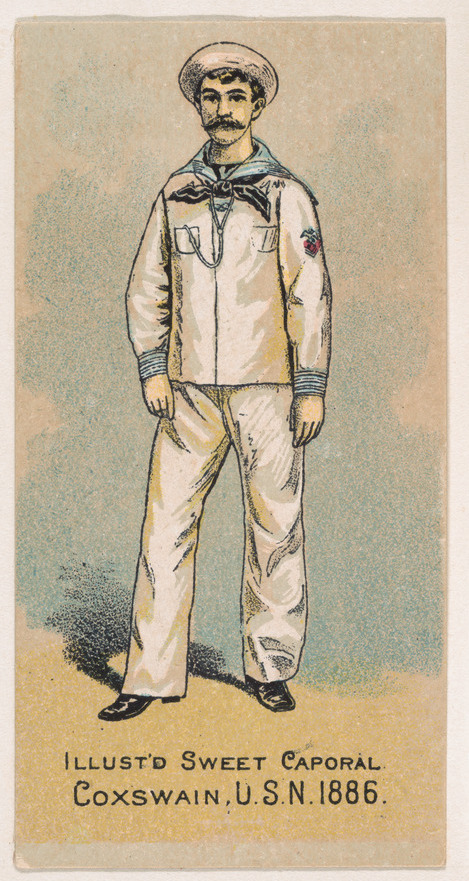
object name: print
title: Coxswain, United States Navy, 1886, from the Military Series (N224) issued by Kinney Tobacco Company to promote Sweet Caporal Cigarettes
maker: kinney brothers tobacco company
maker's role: publisher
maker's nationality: american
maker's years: 1869-2011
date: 1888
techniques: color lithograph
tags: navy,men